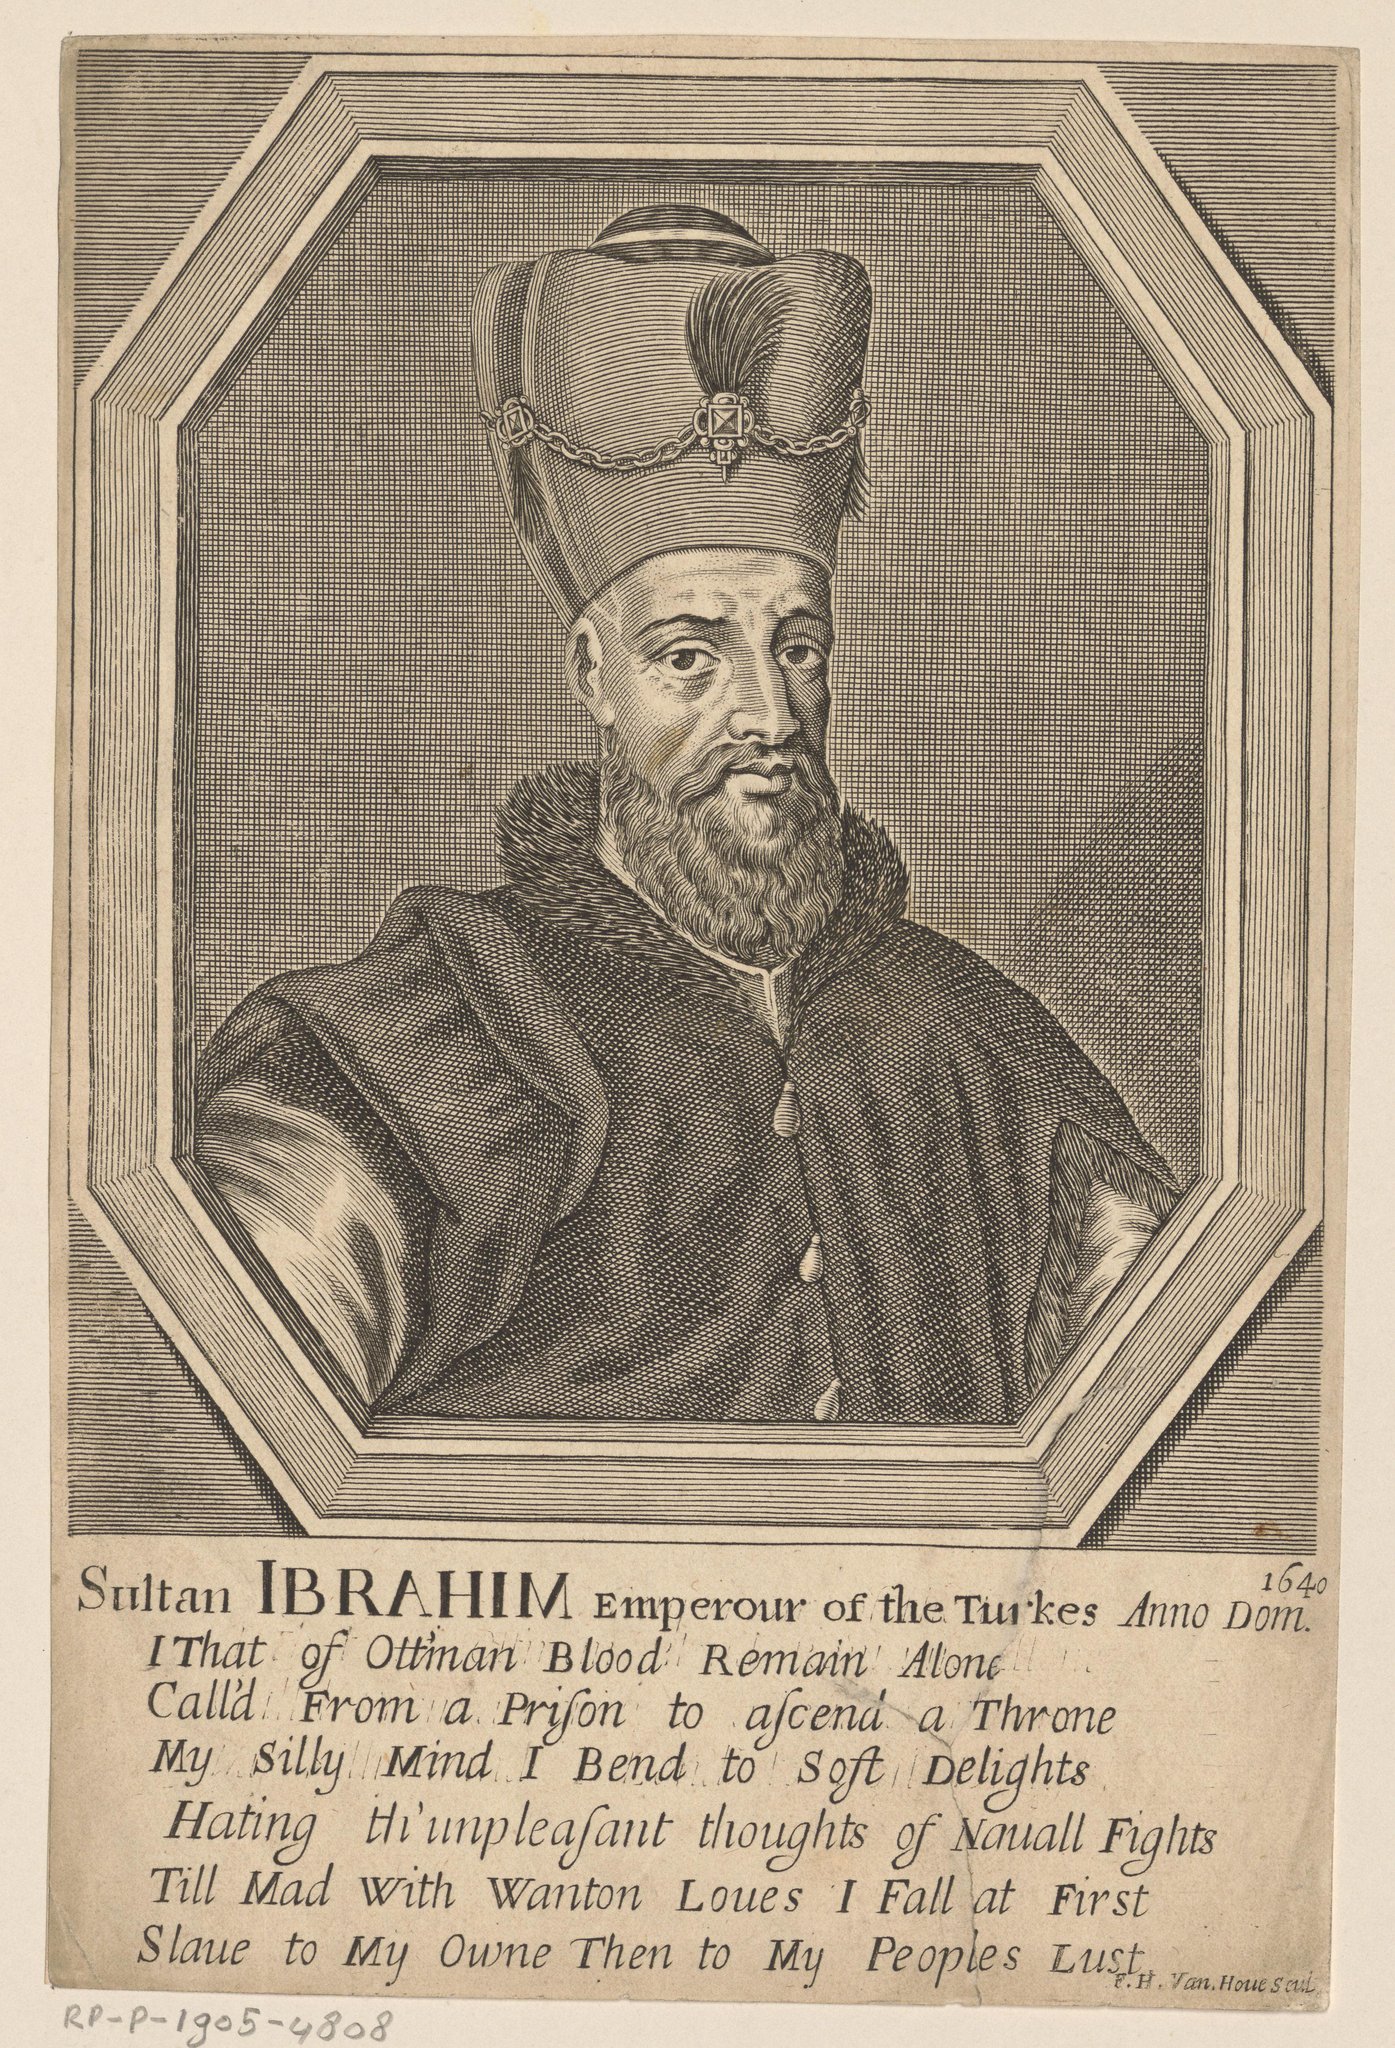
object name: print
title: Portret van Ibrahim I, sultan van Turkije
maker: frederick hendrick van den hove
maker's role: print maker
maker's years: 1628-1698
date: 1679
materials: paper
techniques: engraving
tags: head-gear, historical persons, ruler, sovereign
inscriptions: collector's mark: Lugt 2228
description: Prent mogelijk uit: Rycaut, Paul. The History of the Turkish Empire from the Year 1640 to the Year 1677 (...). Londen: J.M. en John Starkey, 1679.